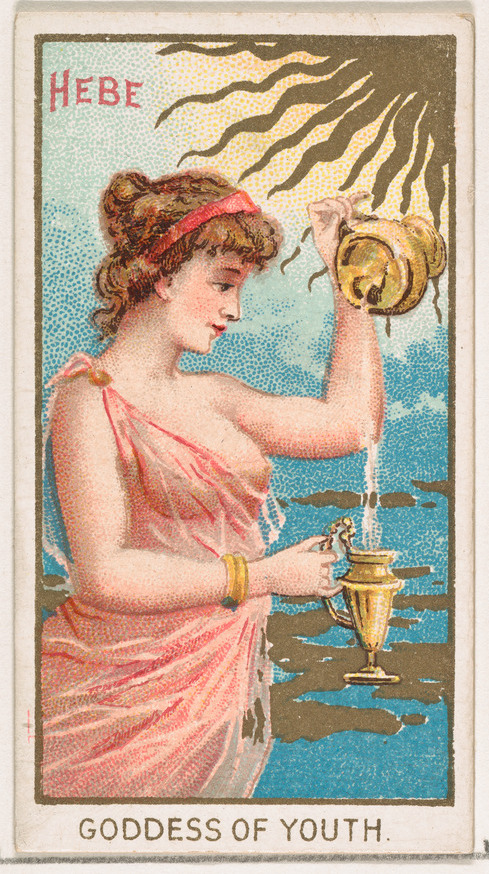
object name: print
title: Hebe, Goddess of Youth, from the Goddesses of the Greeks and Romans series (N188) issued by Wm. S. Kimball & Co.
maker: william s. kimball & company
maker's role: publisher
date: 1889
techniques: color lithograph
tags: goddess